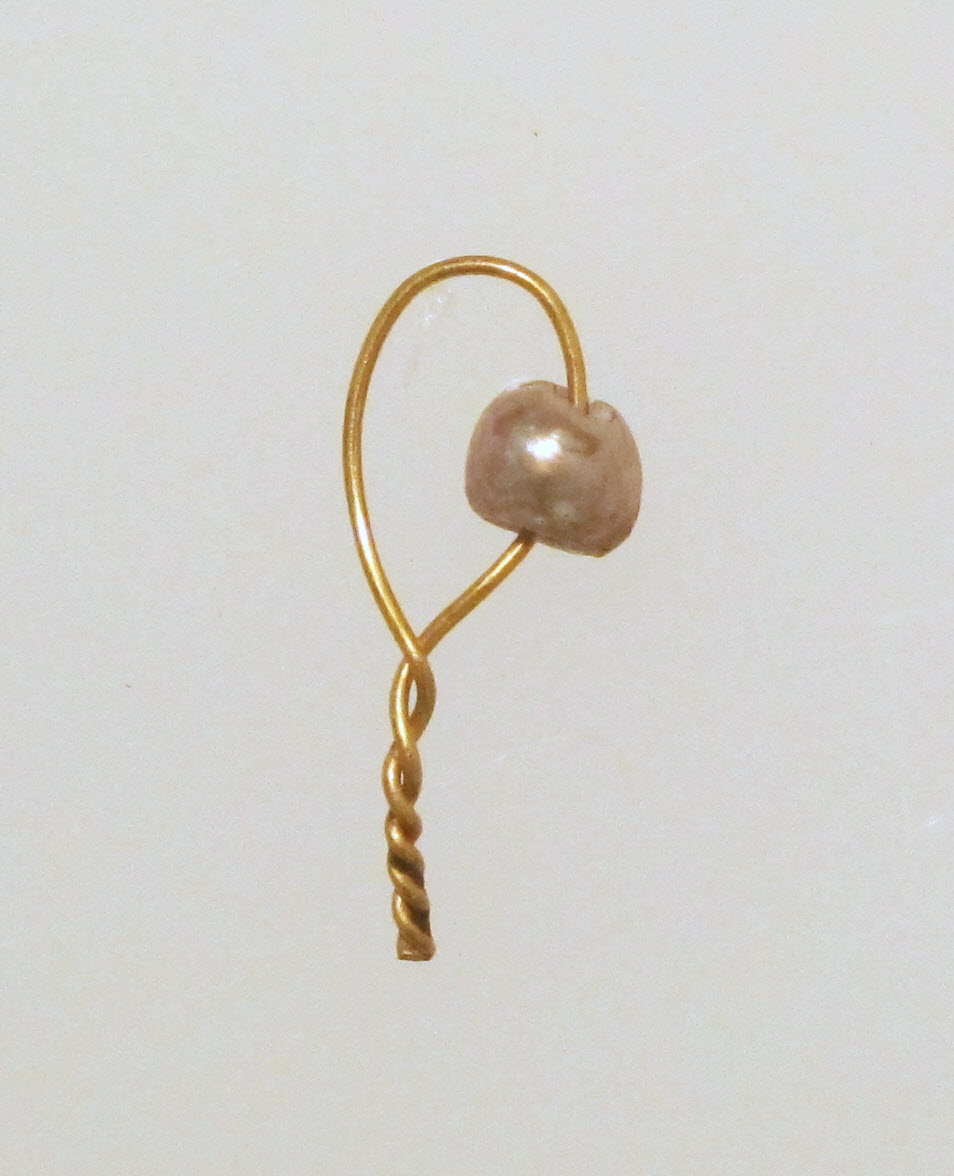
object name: pendant with pearl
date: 7000 BCE-330 CE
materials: gold, pearl